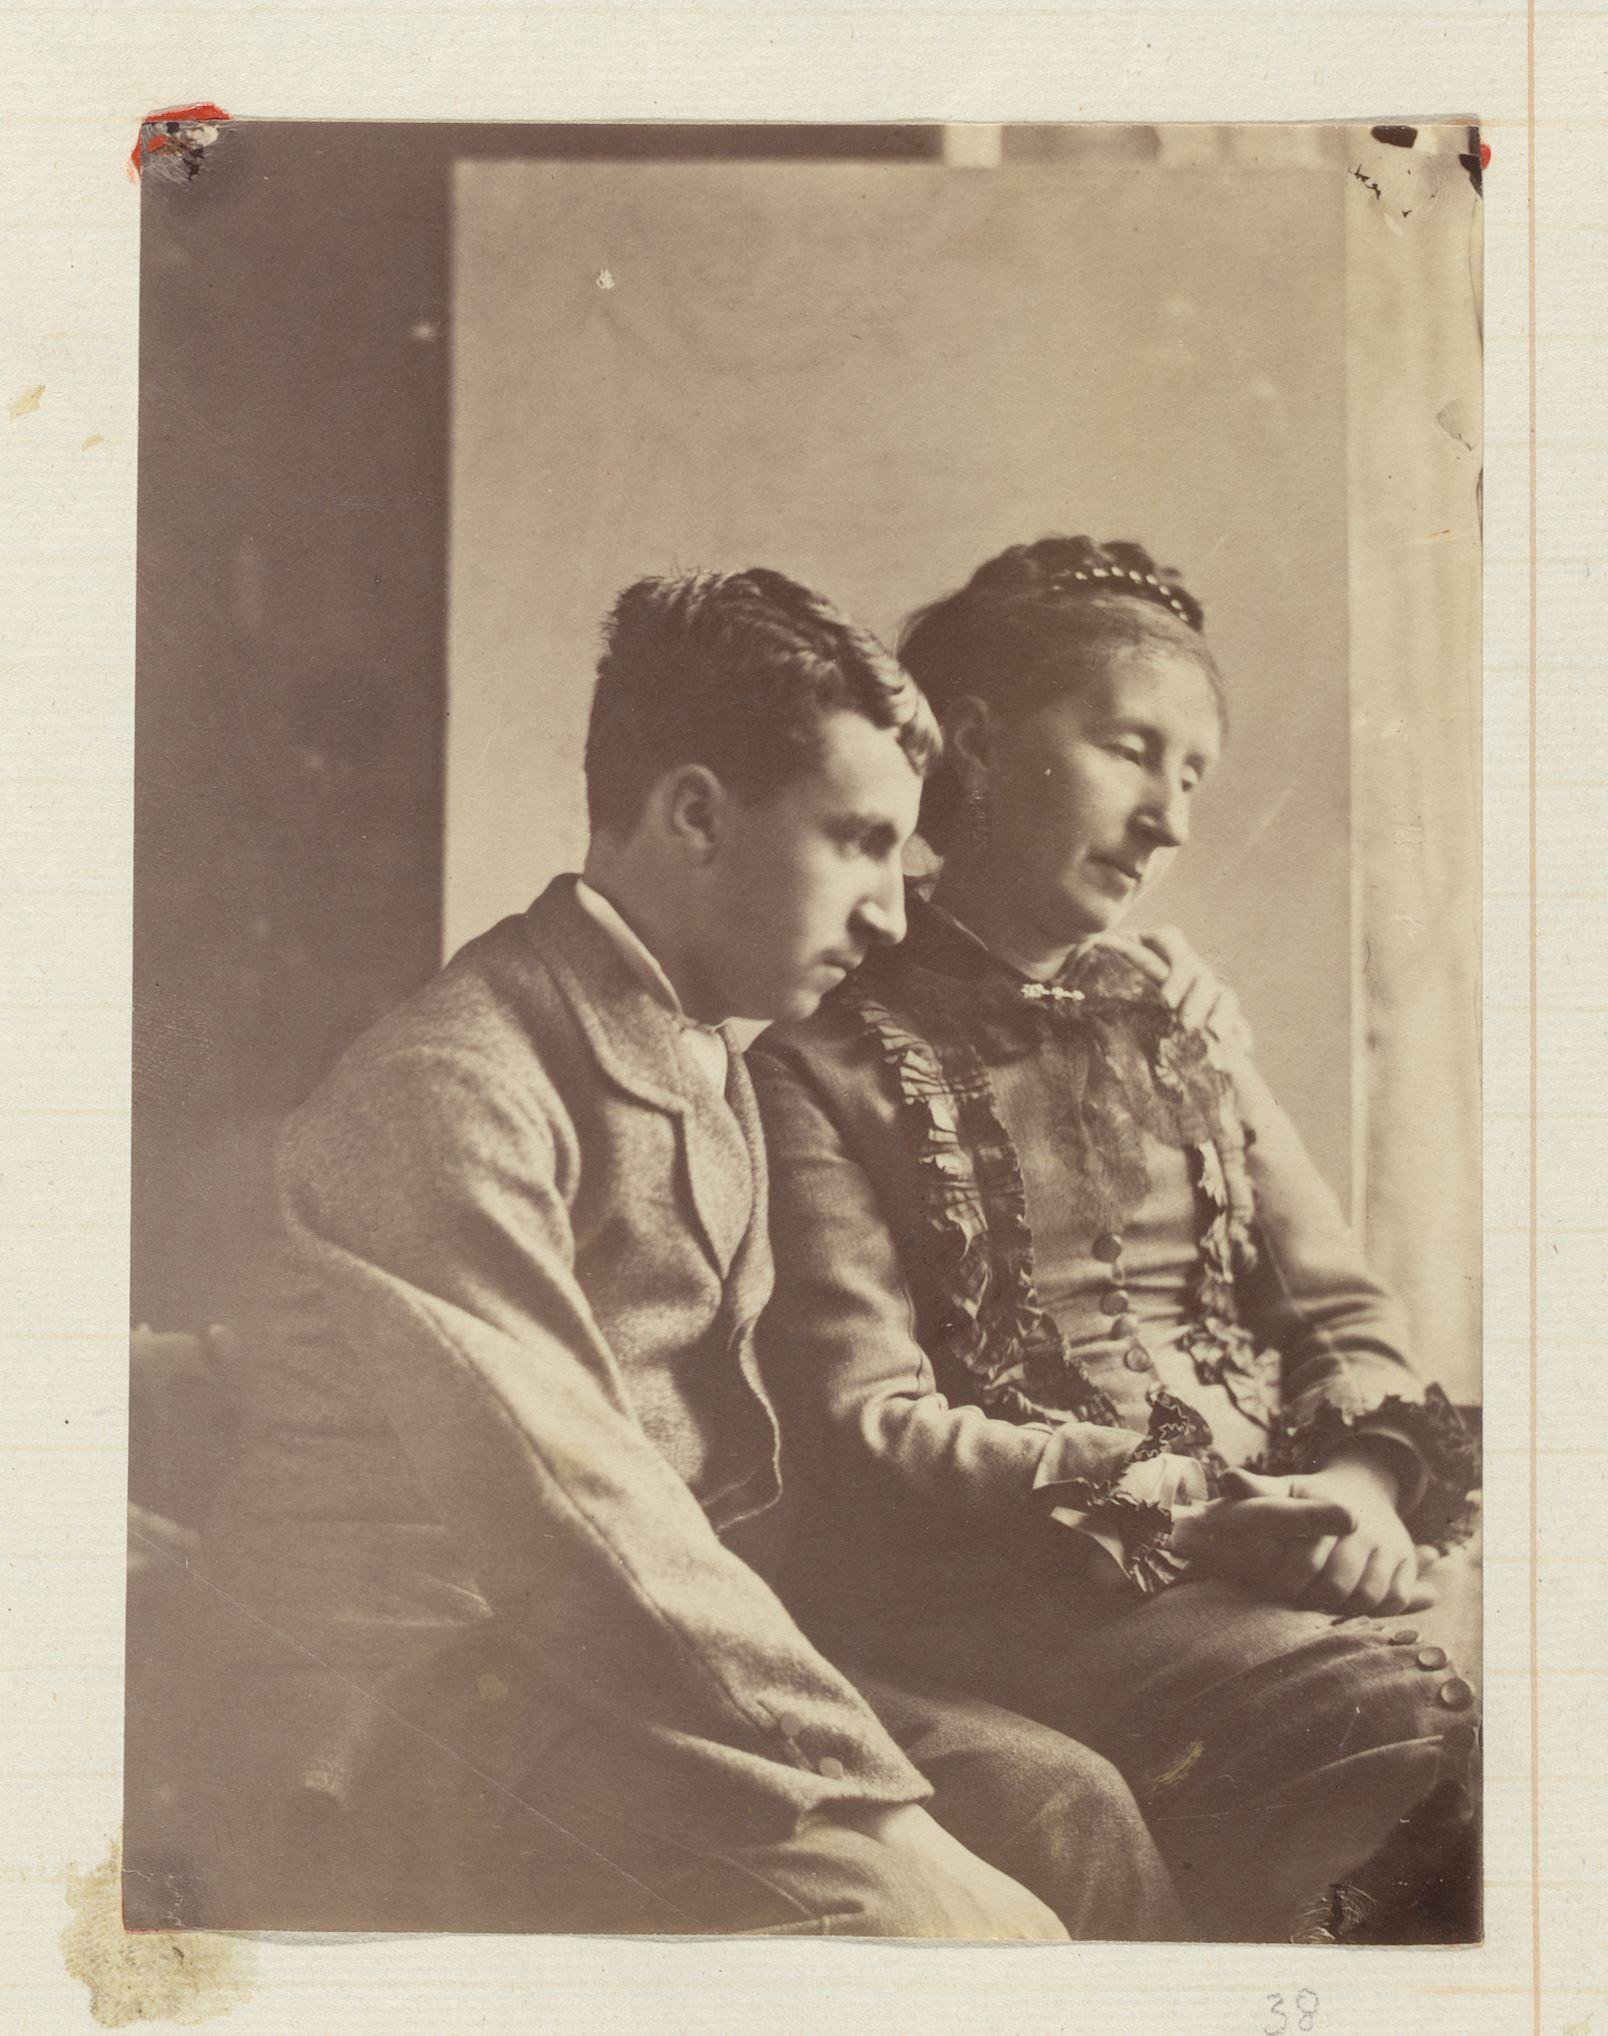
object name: photograph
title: Portret van een vrouw en een jongeman, mogelijk moeder en zoon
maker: Anonymous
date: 1880-1900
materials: paper, photographic support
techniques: albumen print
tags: mother and son(s) (family group)